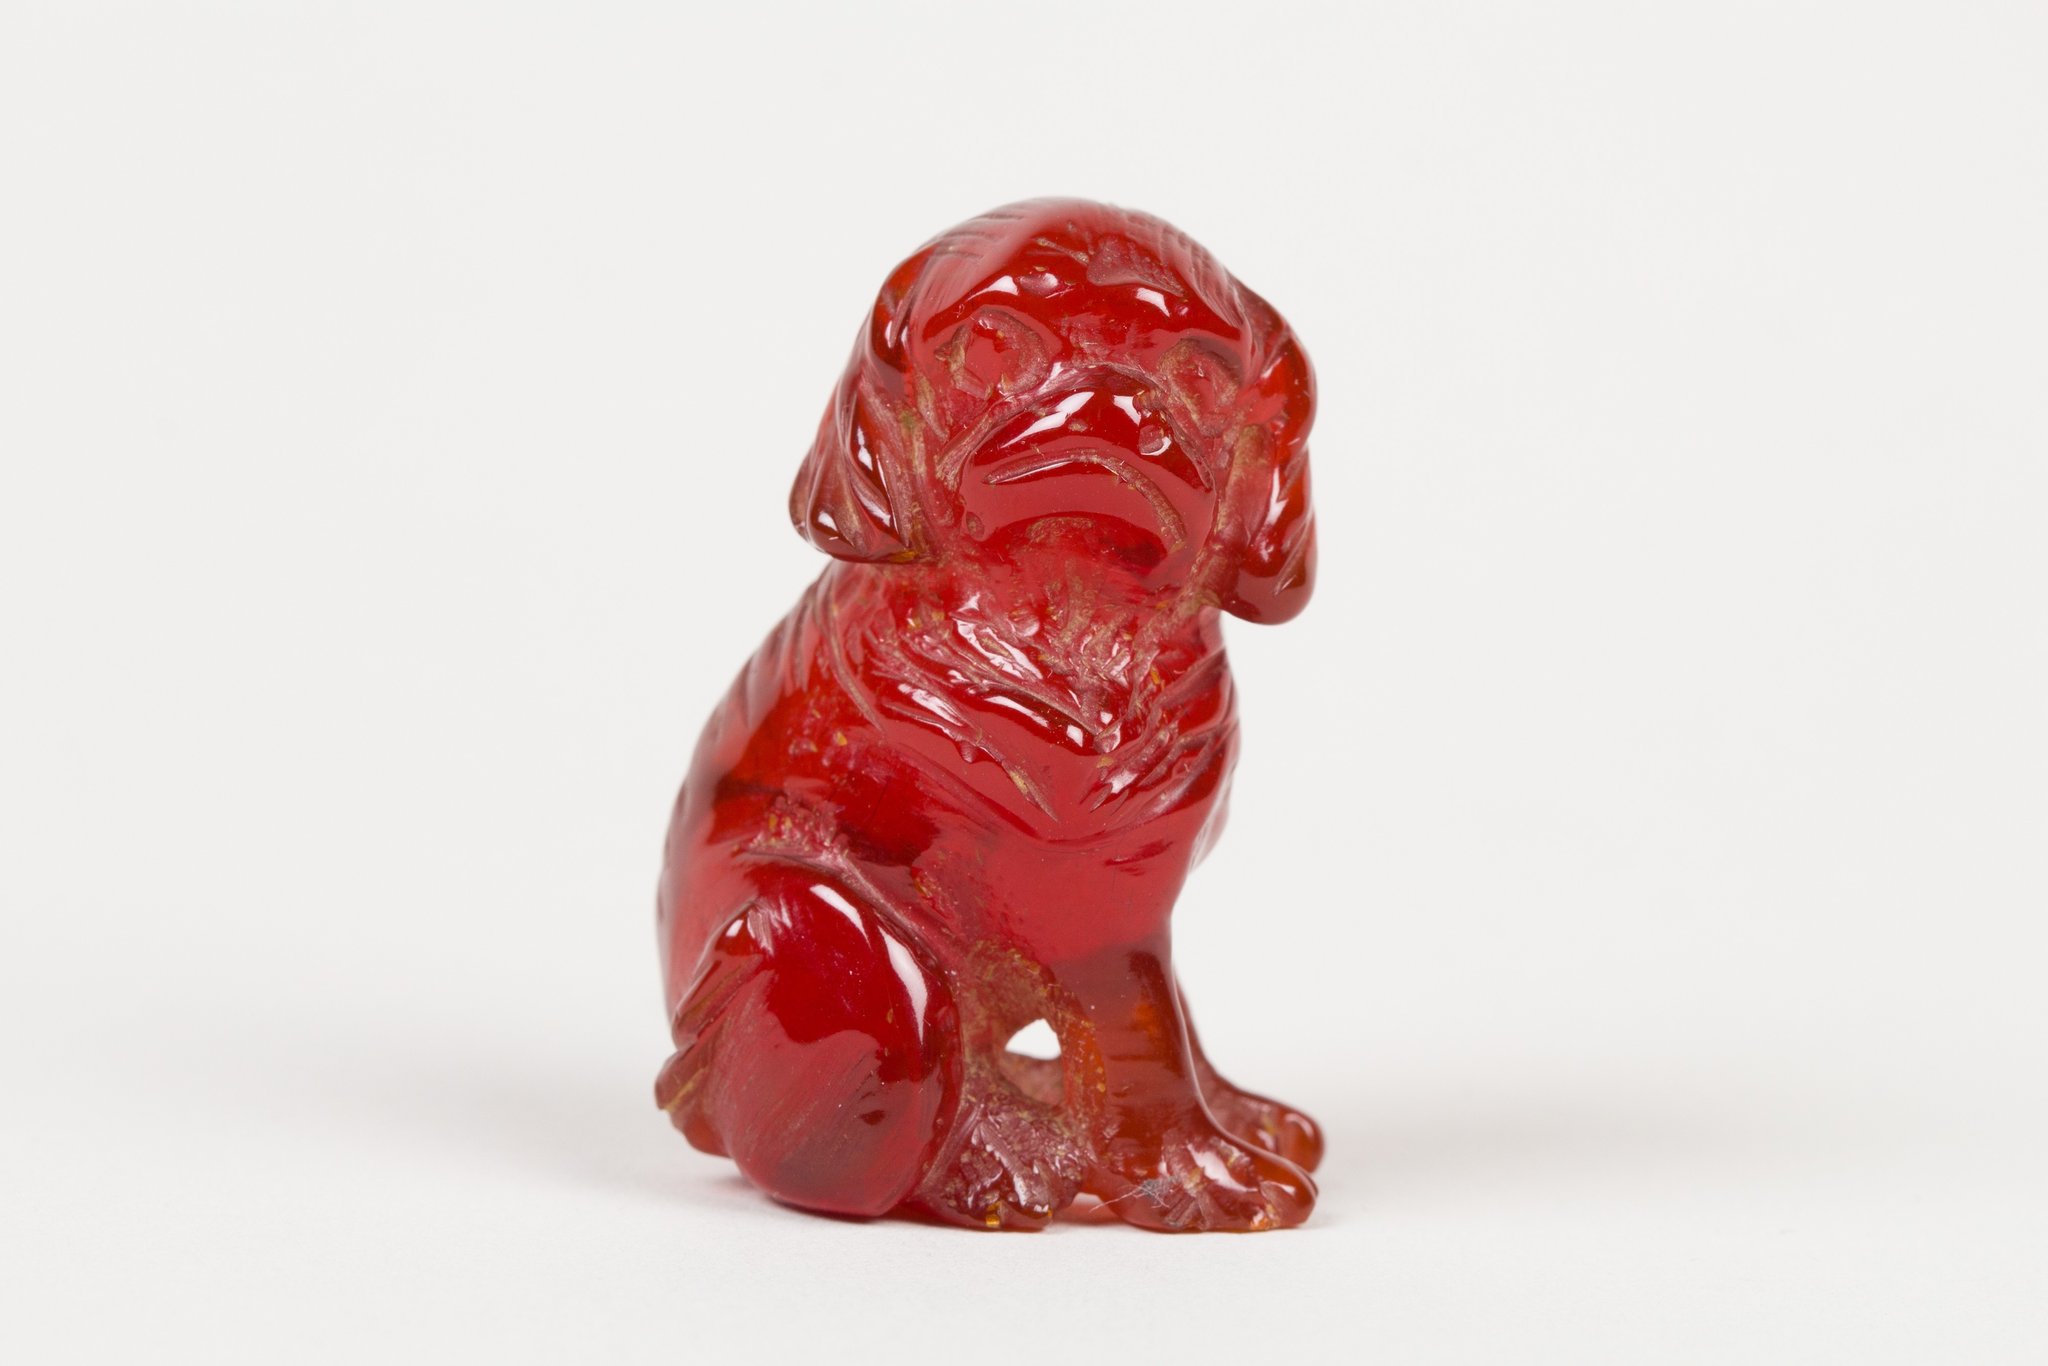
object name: netsuke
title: Netsuke of Seated Dog (one of a pair)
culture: japanese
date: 1867-1933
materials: amber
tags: dogs